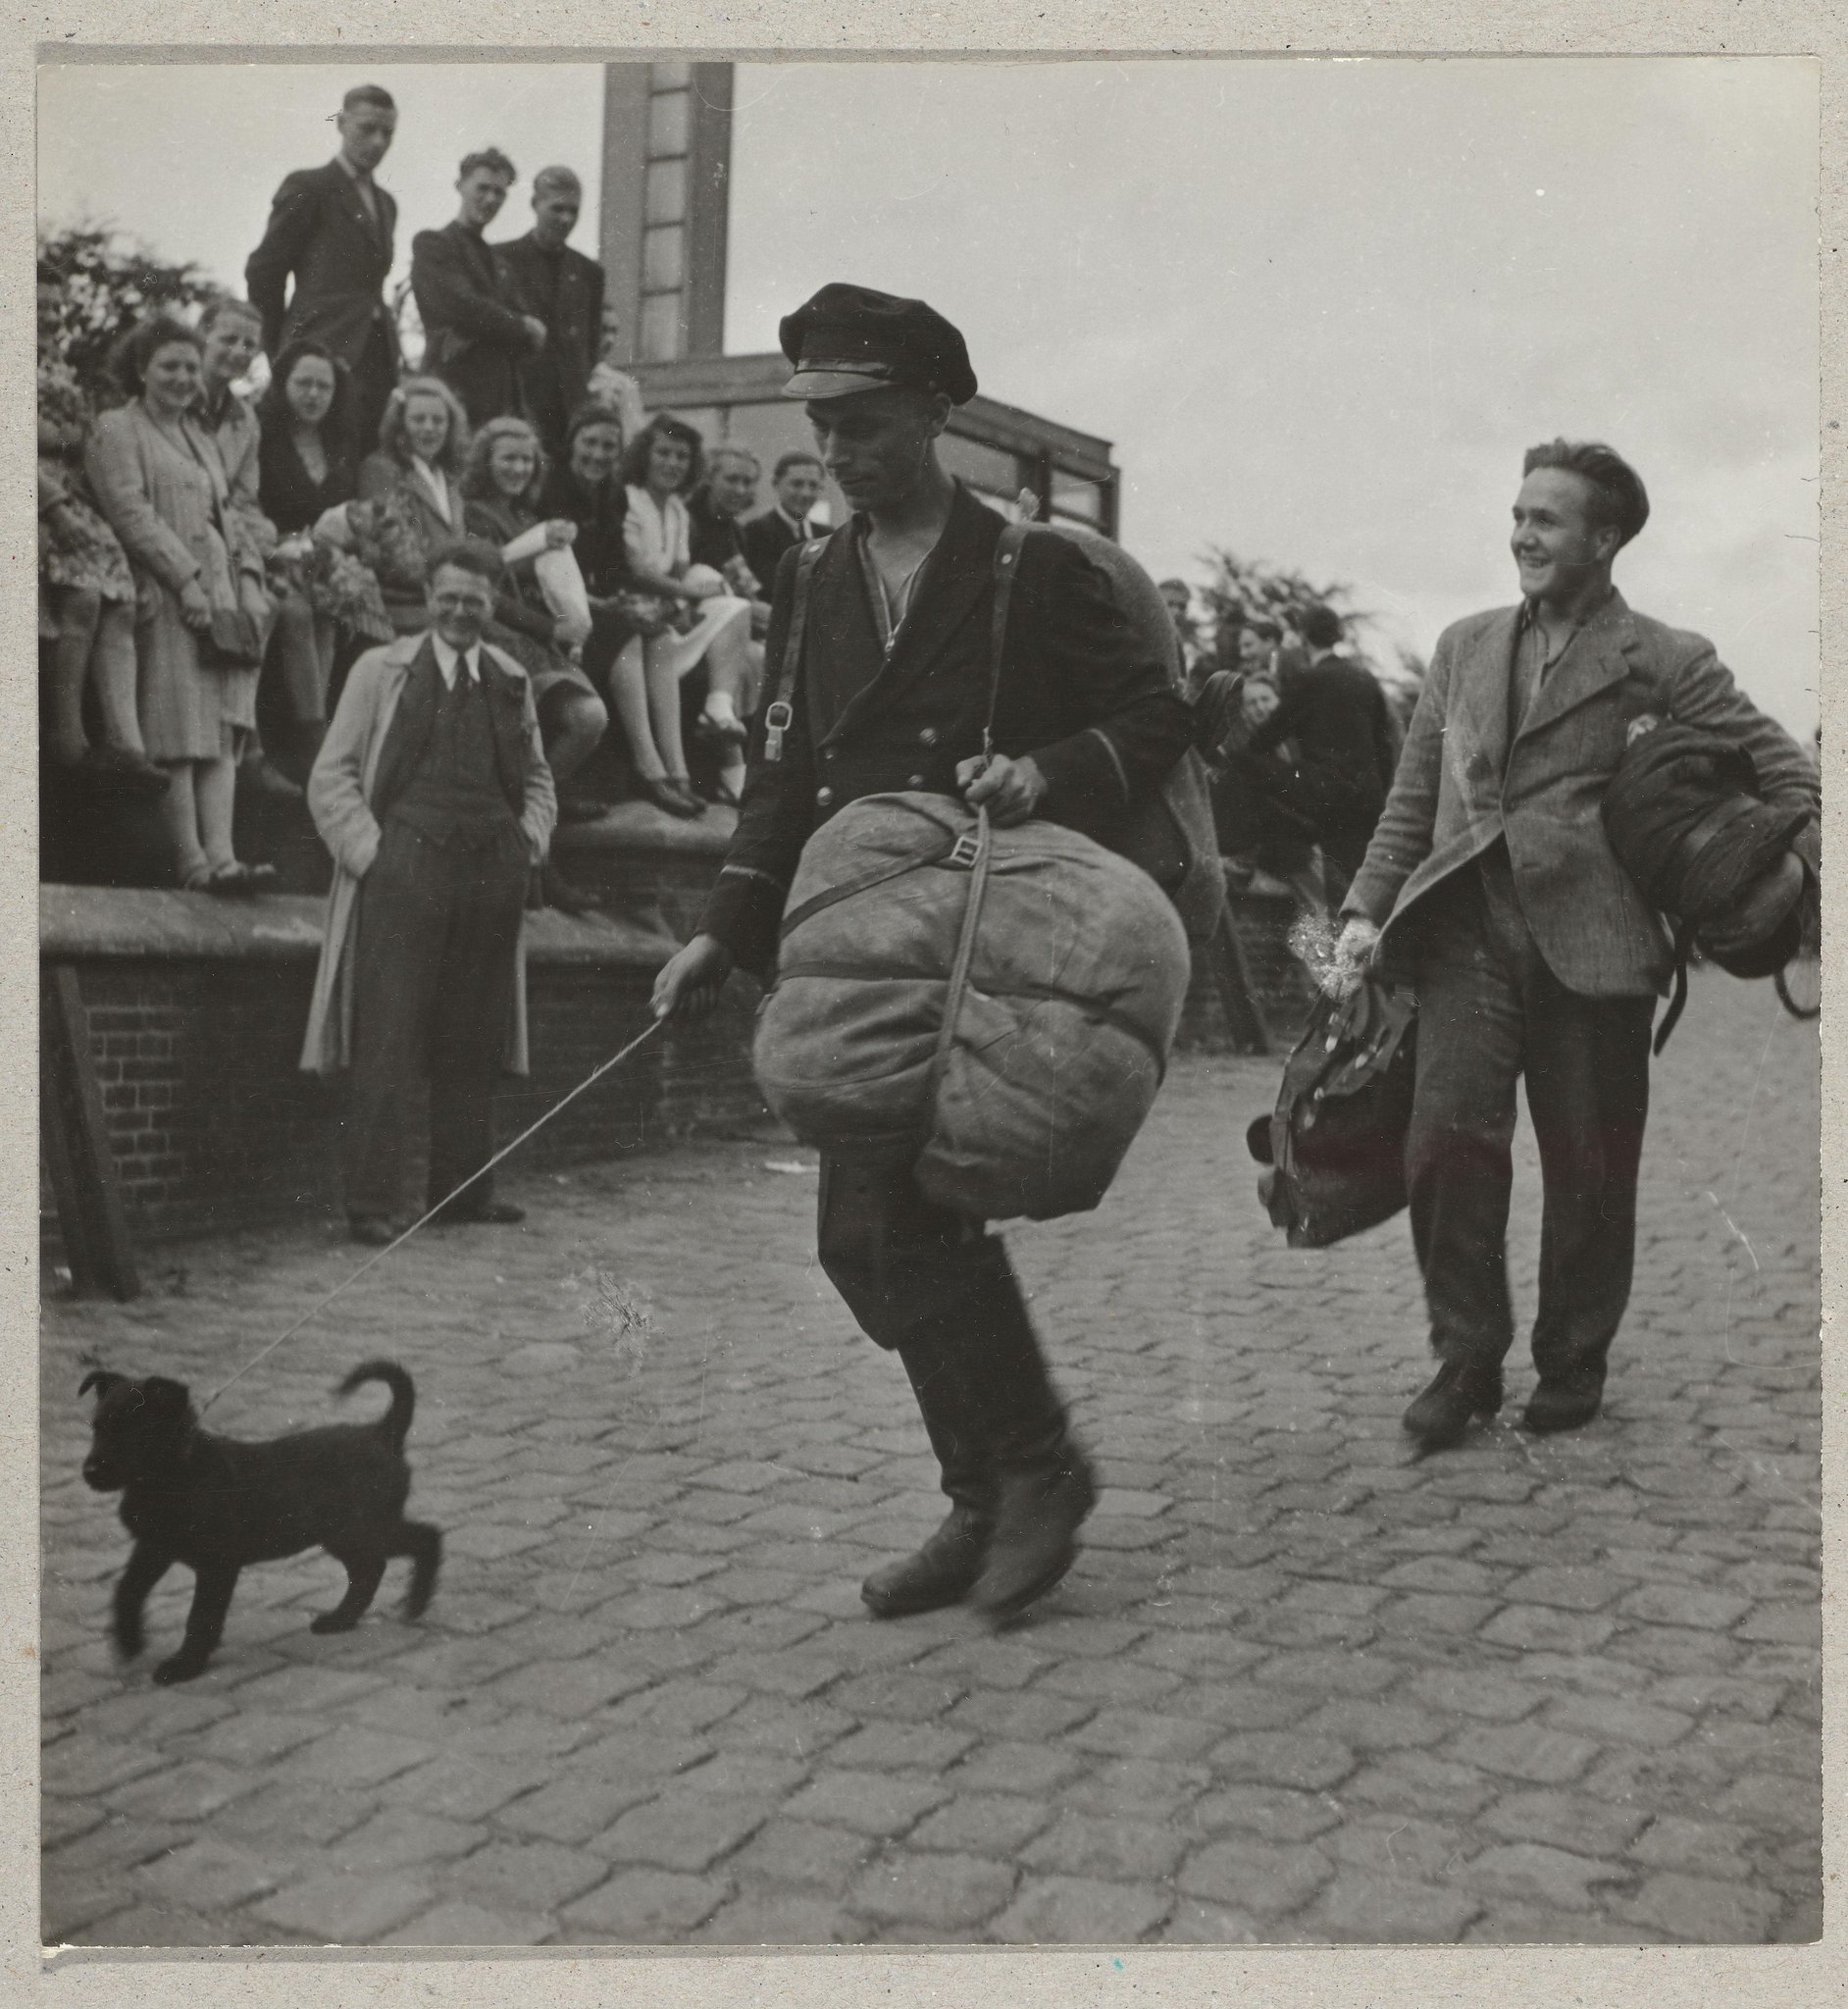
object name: photograph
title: Twee mannen met bepakking en een hondje lopen langs een groep mensen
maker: emmy eugenie andriesse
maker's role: fotograaf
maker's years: 1914-1953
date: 1945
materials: paper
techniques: gelatin silver print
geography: amsterdam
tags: luggage, travel requisites, dog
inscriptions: annotation: ‘Archief exemplaar Na publicatie gelieve te retourneren aan ABC Press, Amsterdam-c n.z. voorburgwal’, annotation: ‘WO II NEDERLAND’